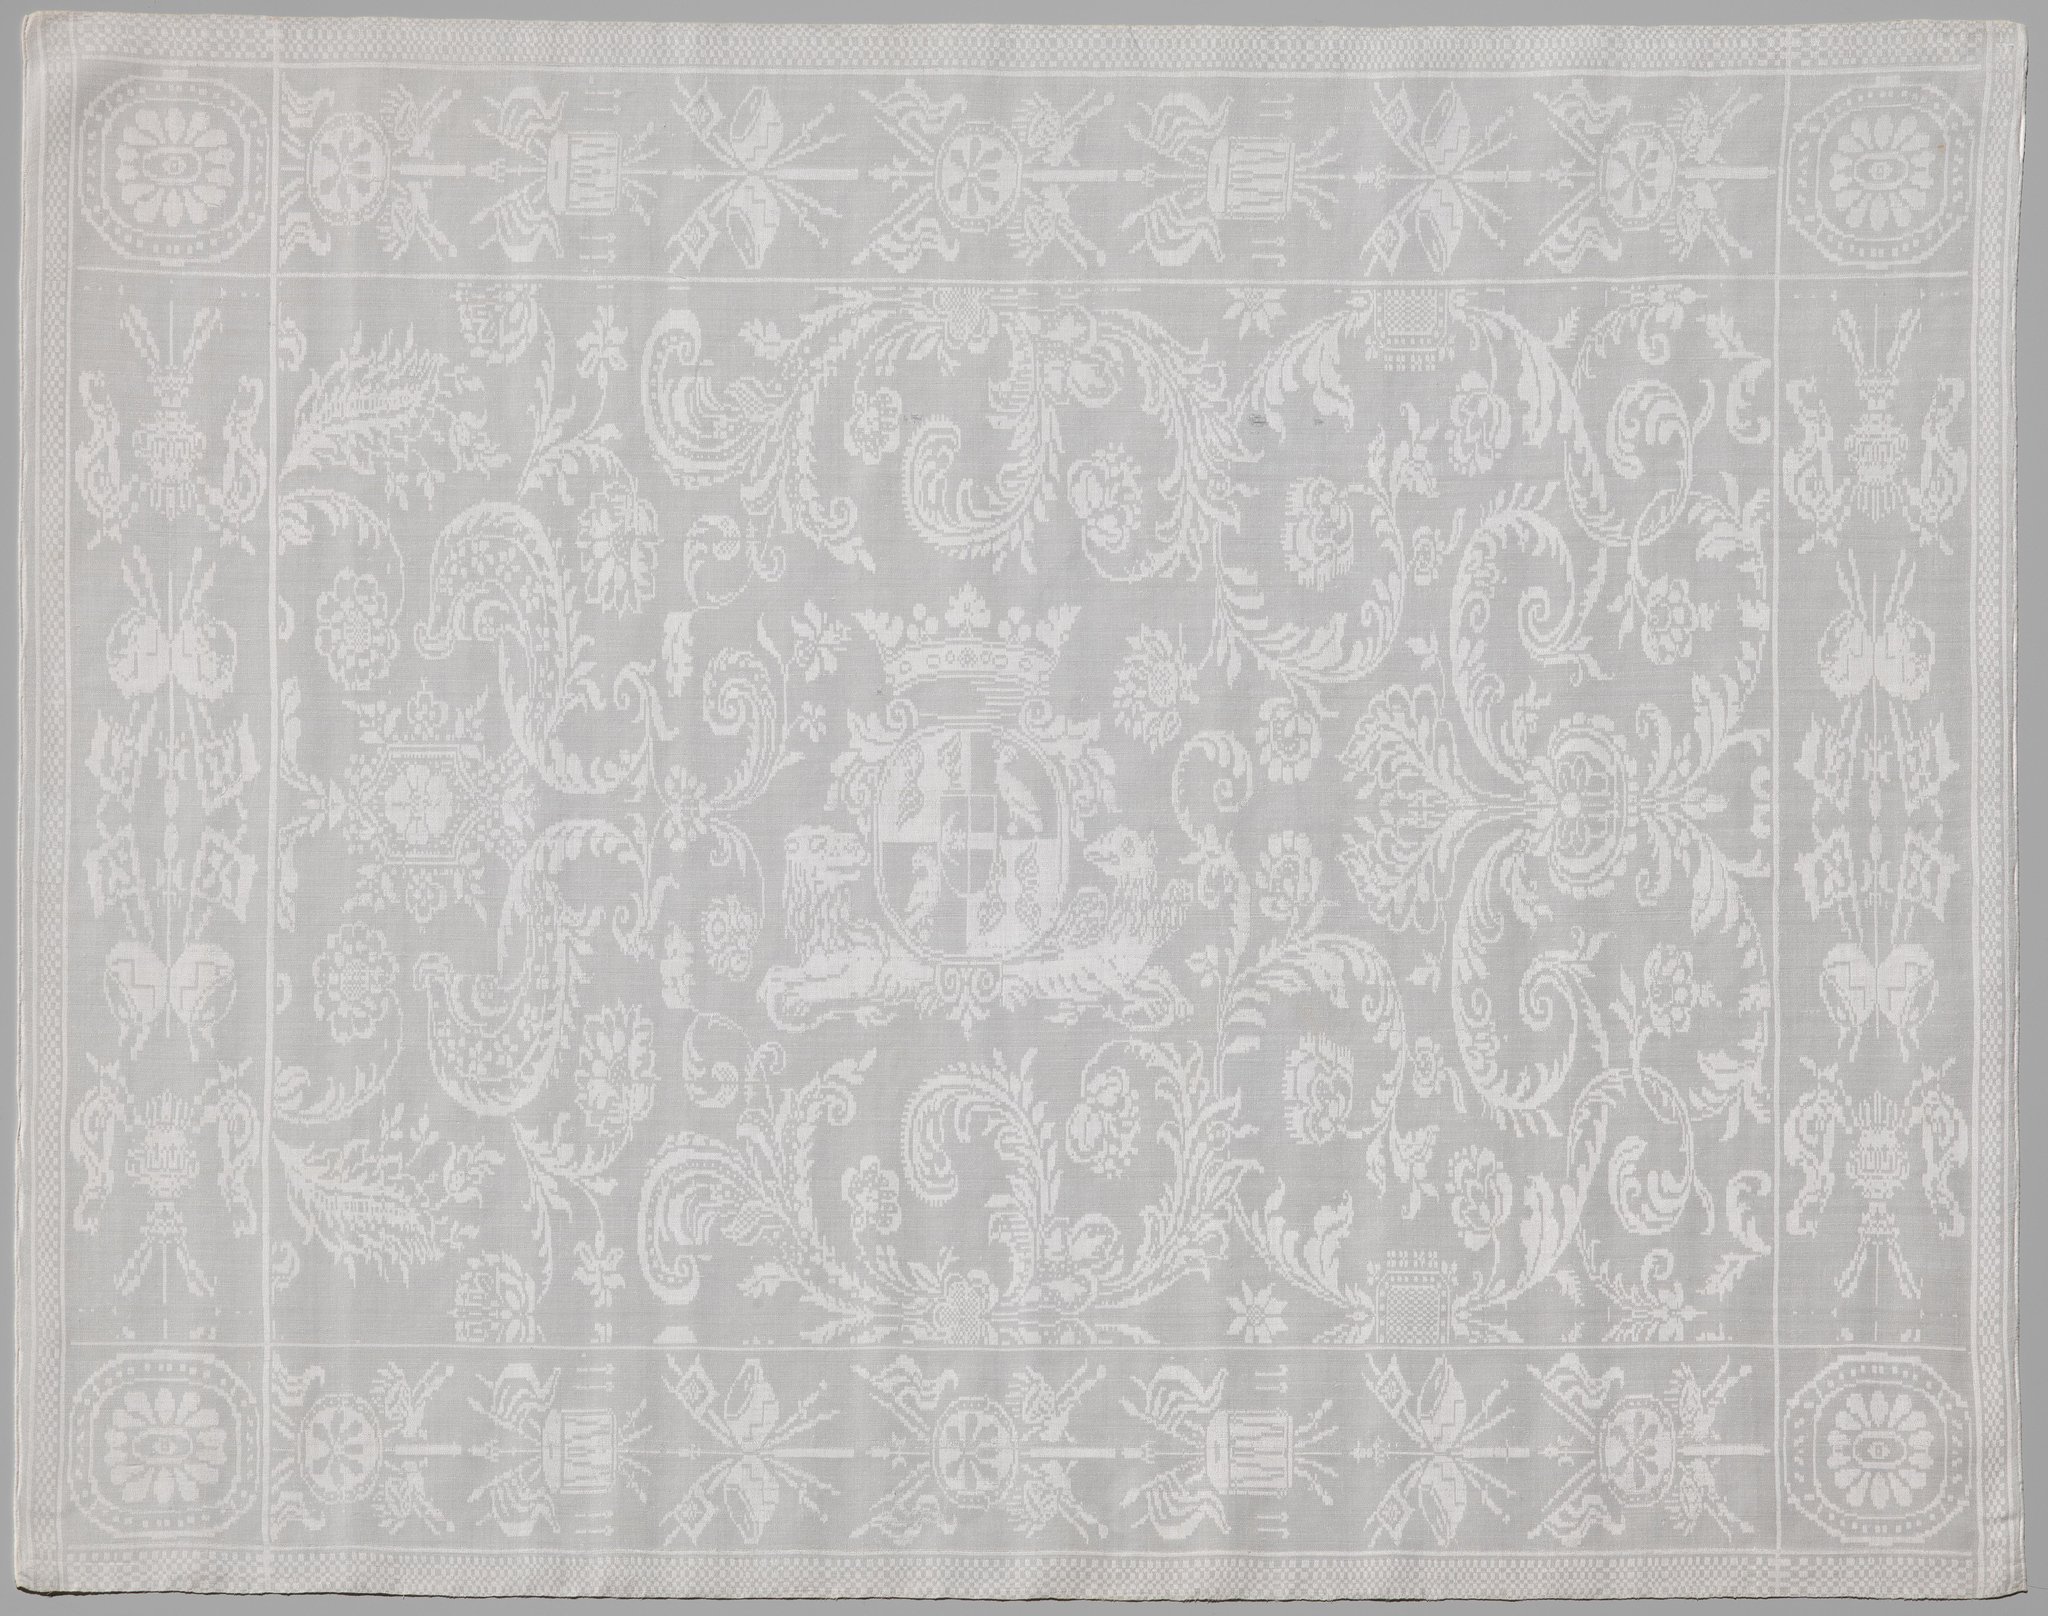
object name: napkin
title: Servet met het wapen van Cornelis Hop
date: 1700-1724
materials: linen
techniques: damask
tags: cornelis hop (ii)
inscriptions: mark: ‘H’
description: Servet van linnendamast met het wapen van Cornelis Hop. Middenveld: symmetrische patroon van veelsoortige voluutranken met op de knooppunten geblokte verdikkingen. Daartussen een liggend ovaal schild met een wapen van Cornelis Hop (1685-1762), ambassadeur aan het hof van koning Lodewijk XV van Frankrijk: gevierendeeld, 1 en 4 kopvogel staande op bol (de vogel van 1 omgewend, die van 4 omziend); 2 en drie twee afgewende vleugels. Hartschild gedeeld: 1 een dwarsbalk, 2 rechts een vijfpuntige ster, links een gewende wassenaar. Het schild gedekt met vijfbladerige kroon. Schildhouders: rechts een afgewende adelaar, links een afgewende leeuw. Randen: wapentrofeeën. Hoeken: een rondas. Rondom blokkenrand.